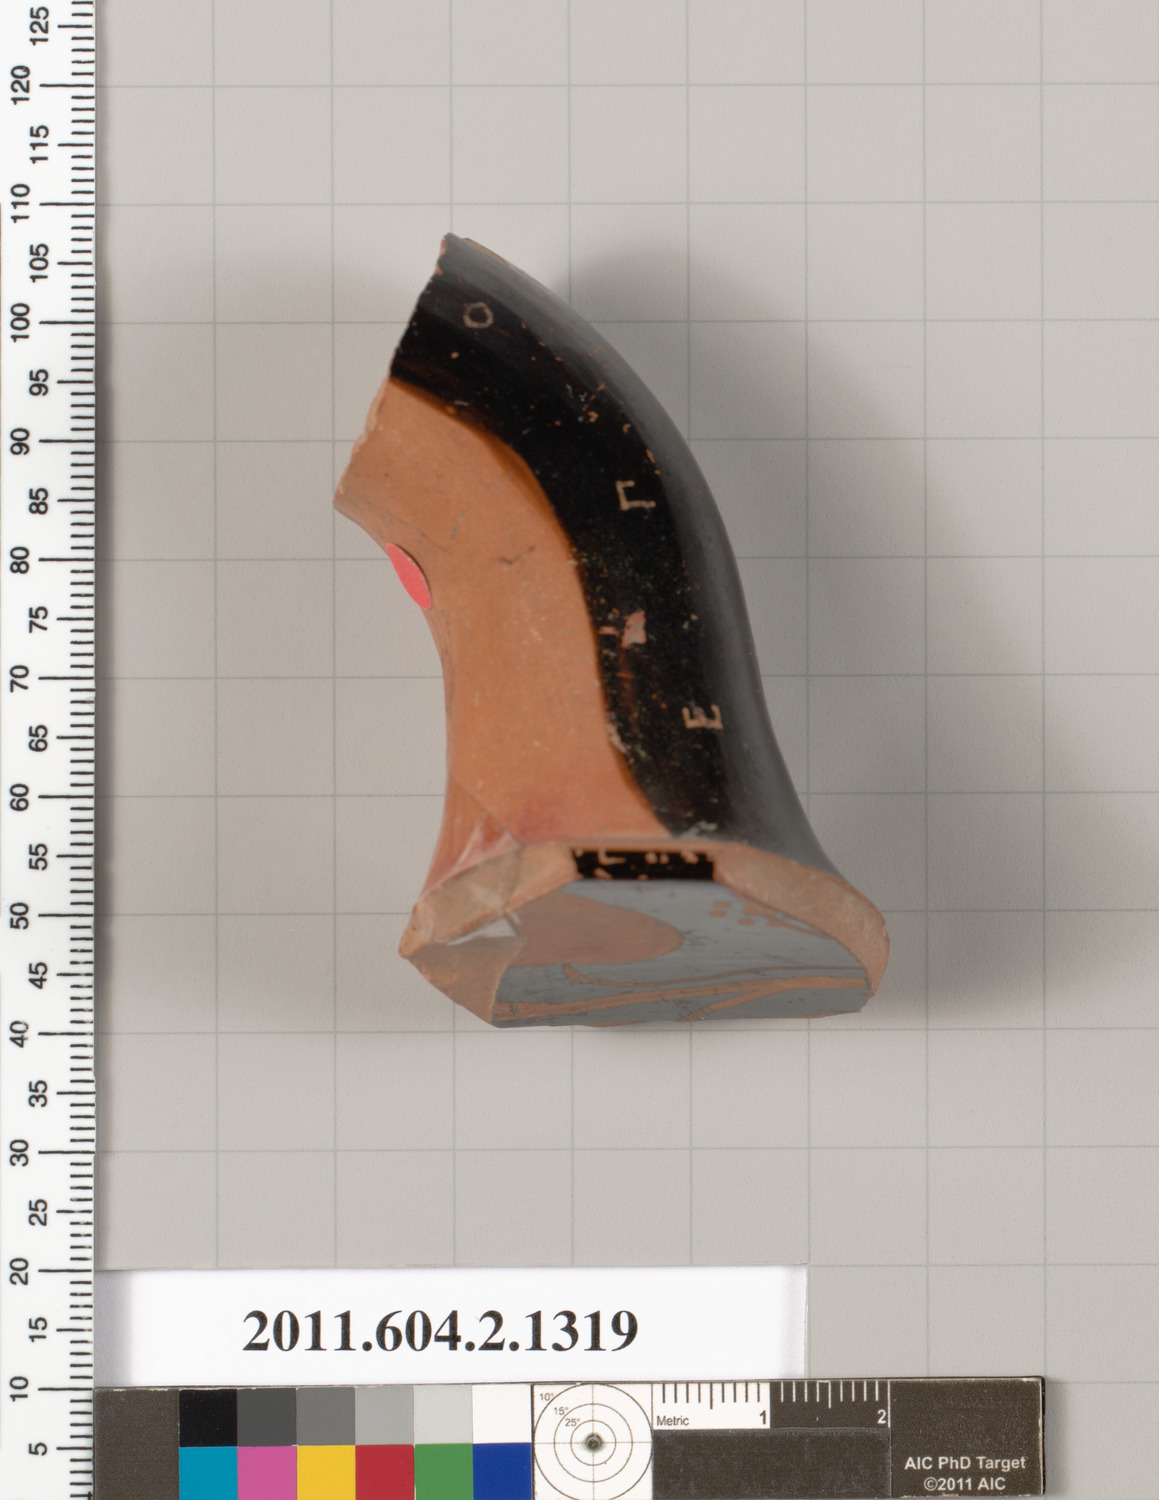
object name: skyphos fragment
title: Terracotta fragment of a skyphos (deep drinking cup)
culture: greek, attic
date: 500-480 BCE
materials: terracotta